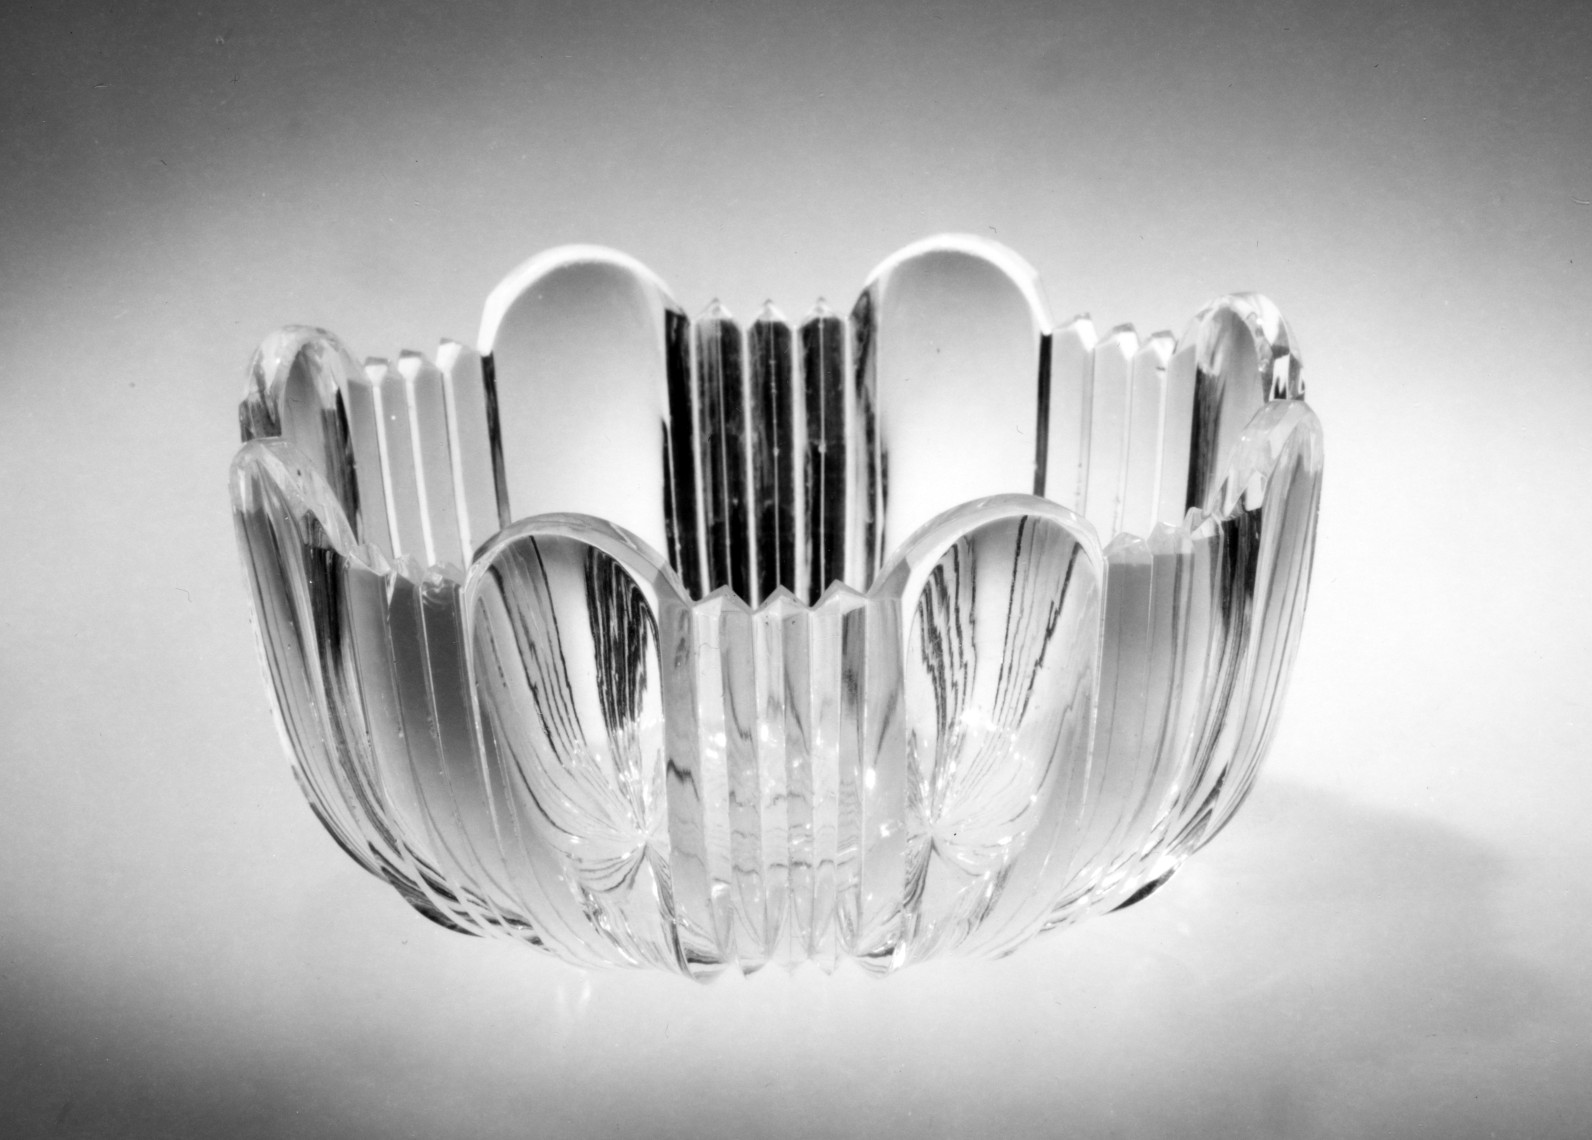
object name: finger bowl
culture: american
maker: christian dorflinger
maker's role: maker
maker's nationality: french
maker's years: 1828-1915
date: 1856-1885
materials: glass, lead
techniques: glassblowing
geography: united states